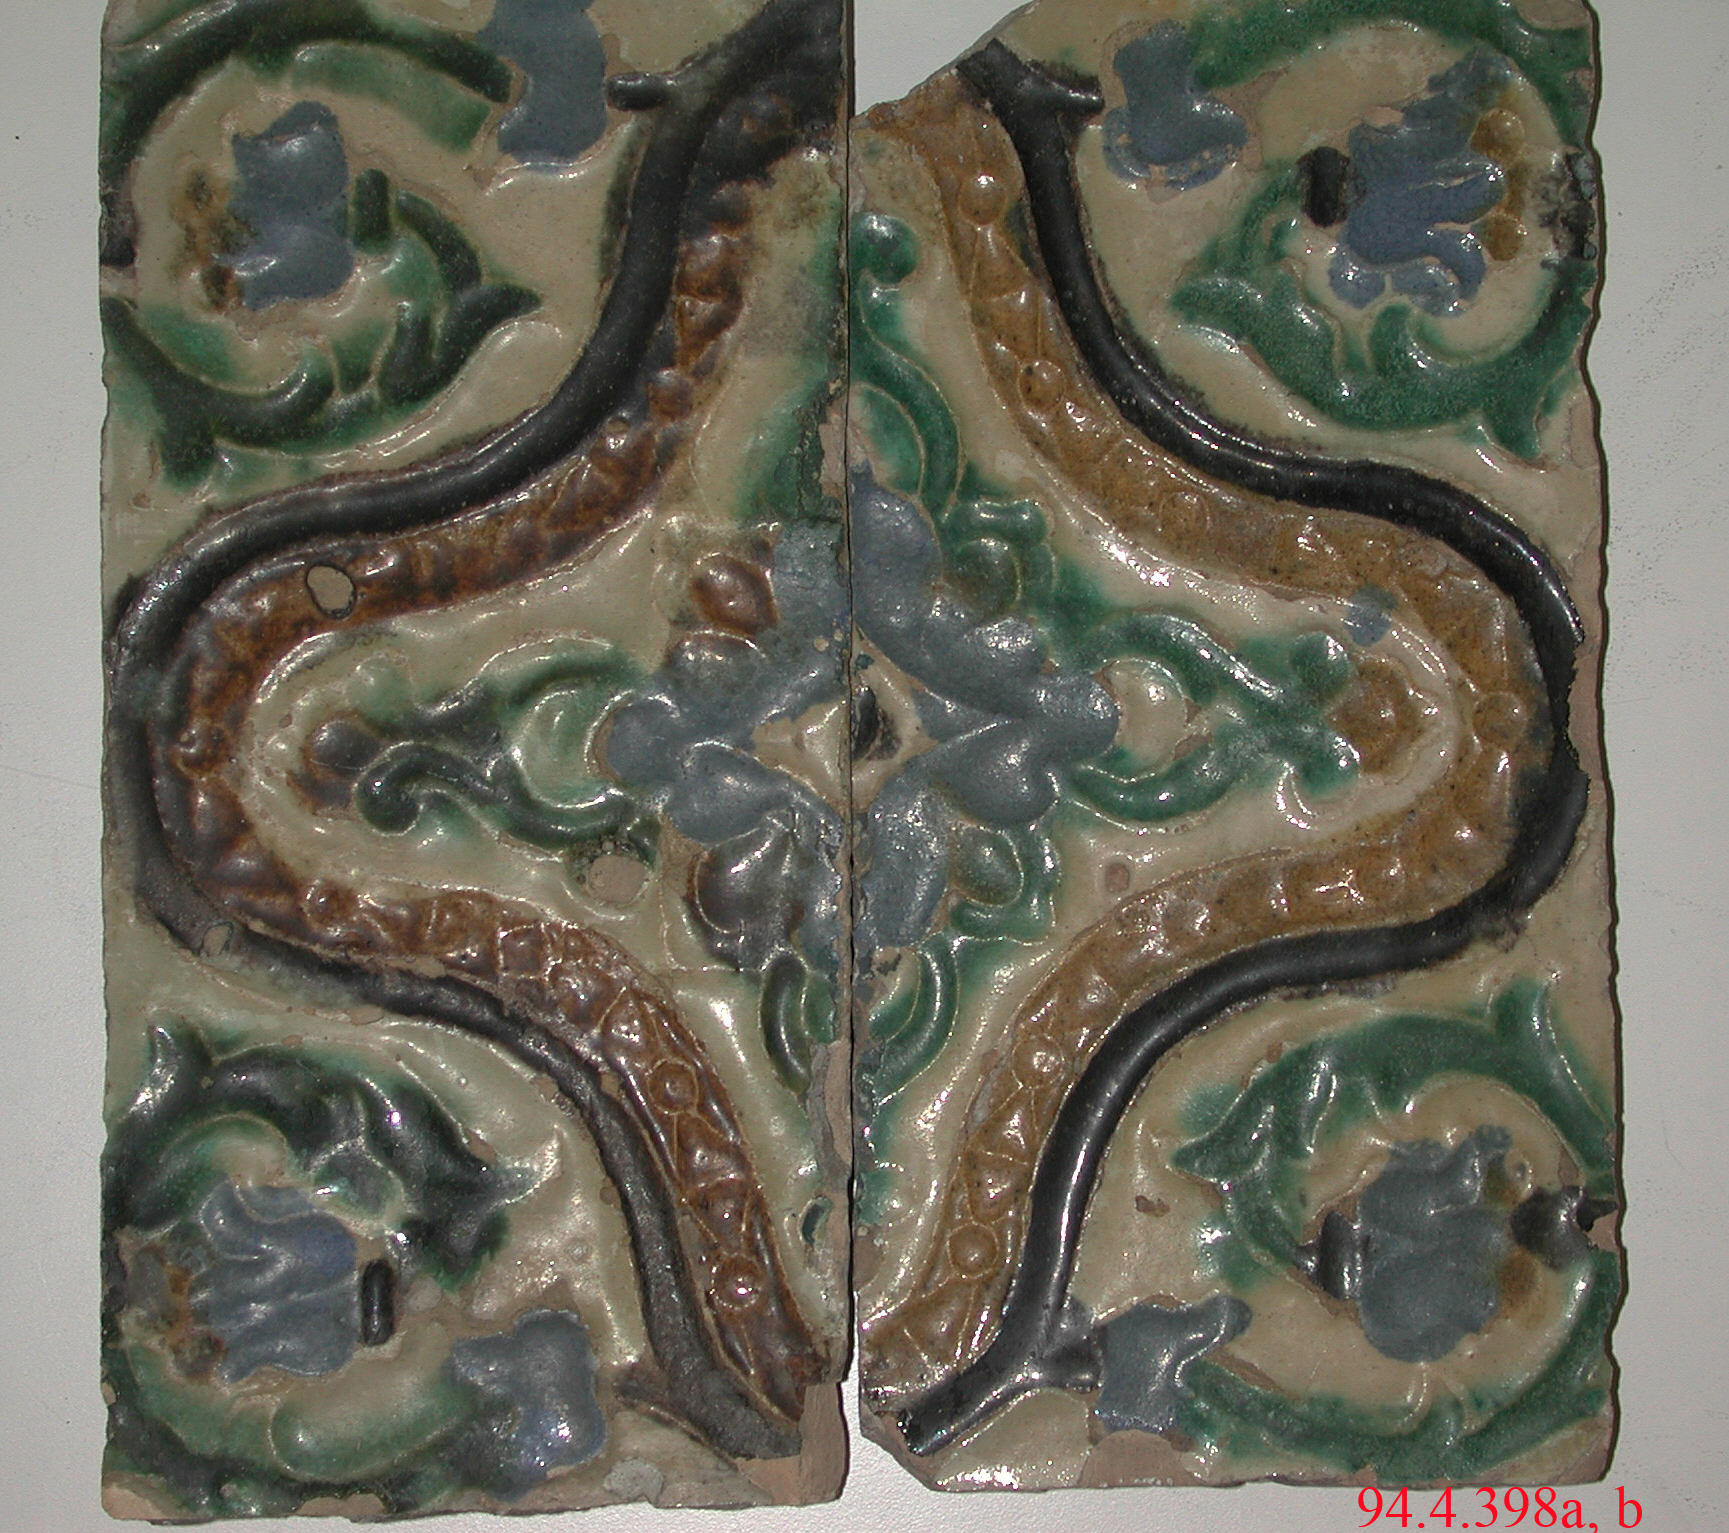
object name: tile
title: Tiles (2)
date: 1501-1700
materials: earthenware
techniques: glazing